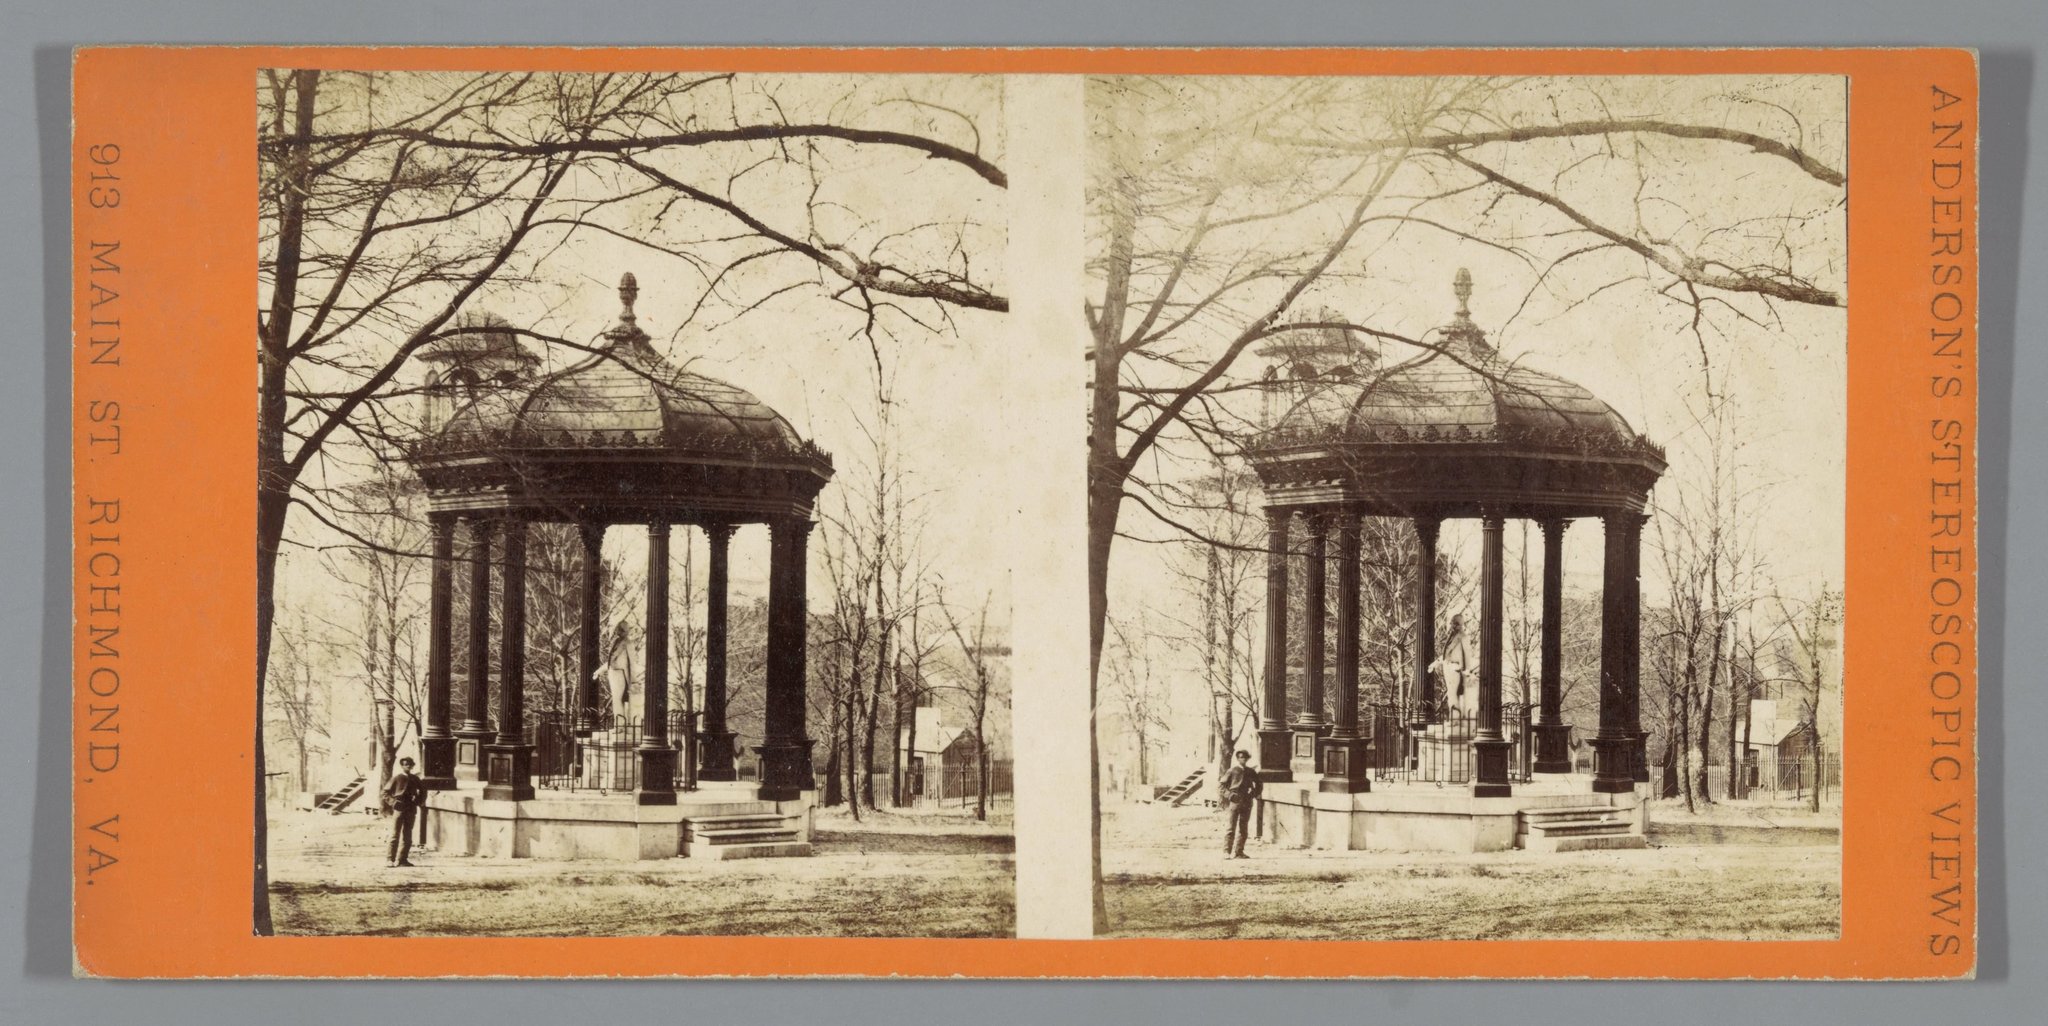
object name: stereograph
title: Views of Richmond and Vicinity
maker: david h. anderson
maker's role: fotograaf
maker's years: 1827-1905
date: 1875-1879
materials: cardboard, paper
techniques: albumen print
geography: richmond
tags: monument, statue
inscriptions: address: ‘913 Main St. Richmond, Va.’, : ‘Views of Richmond (...) and Colonial Relics.’